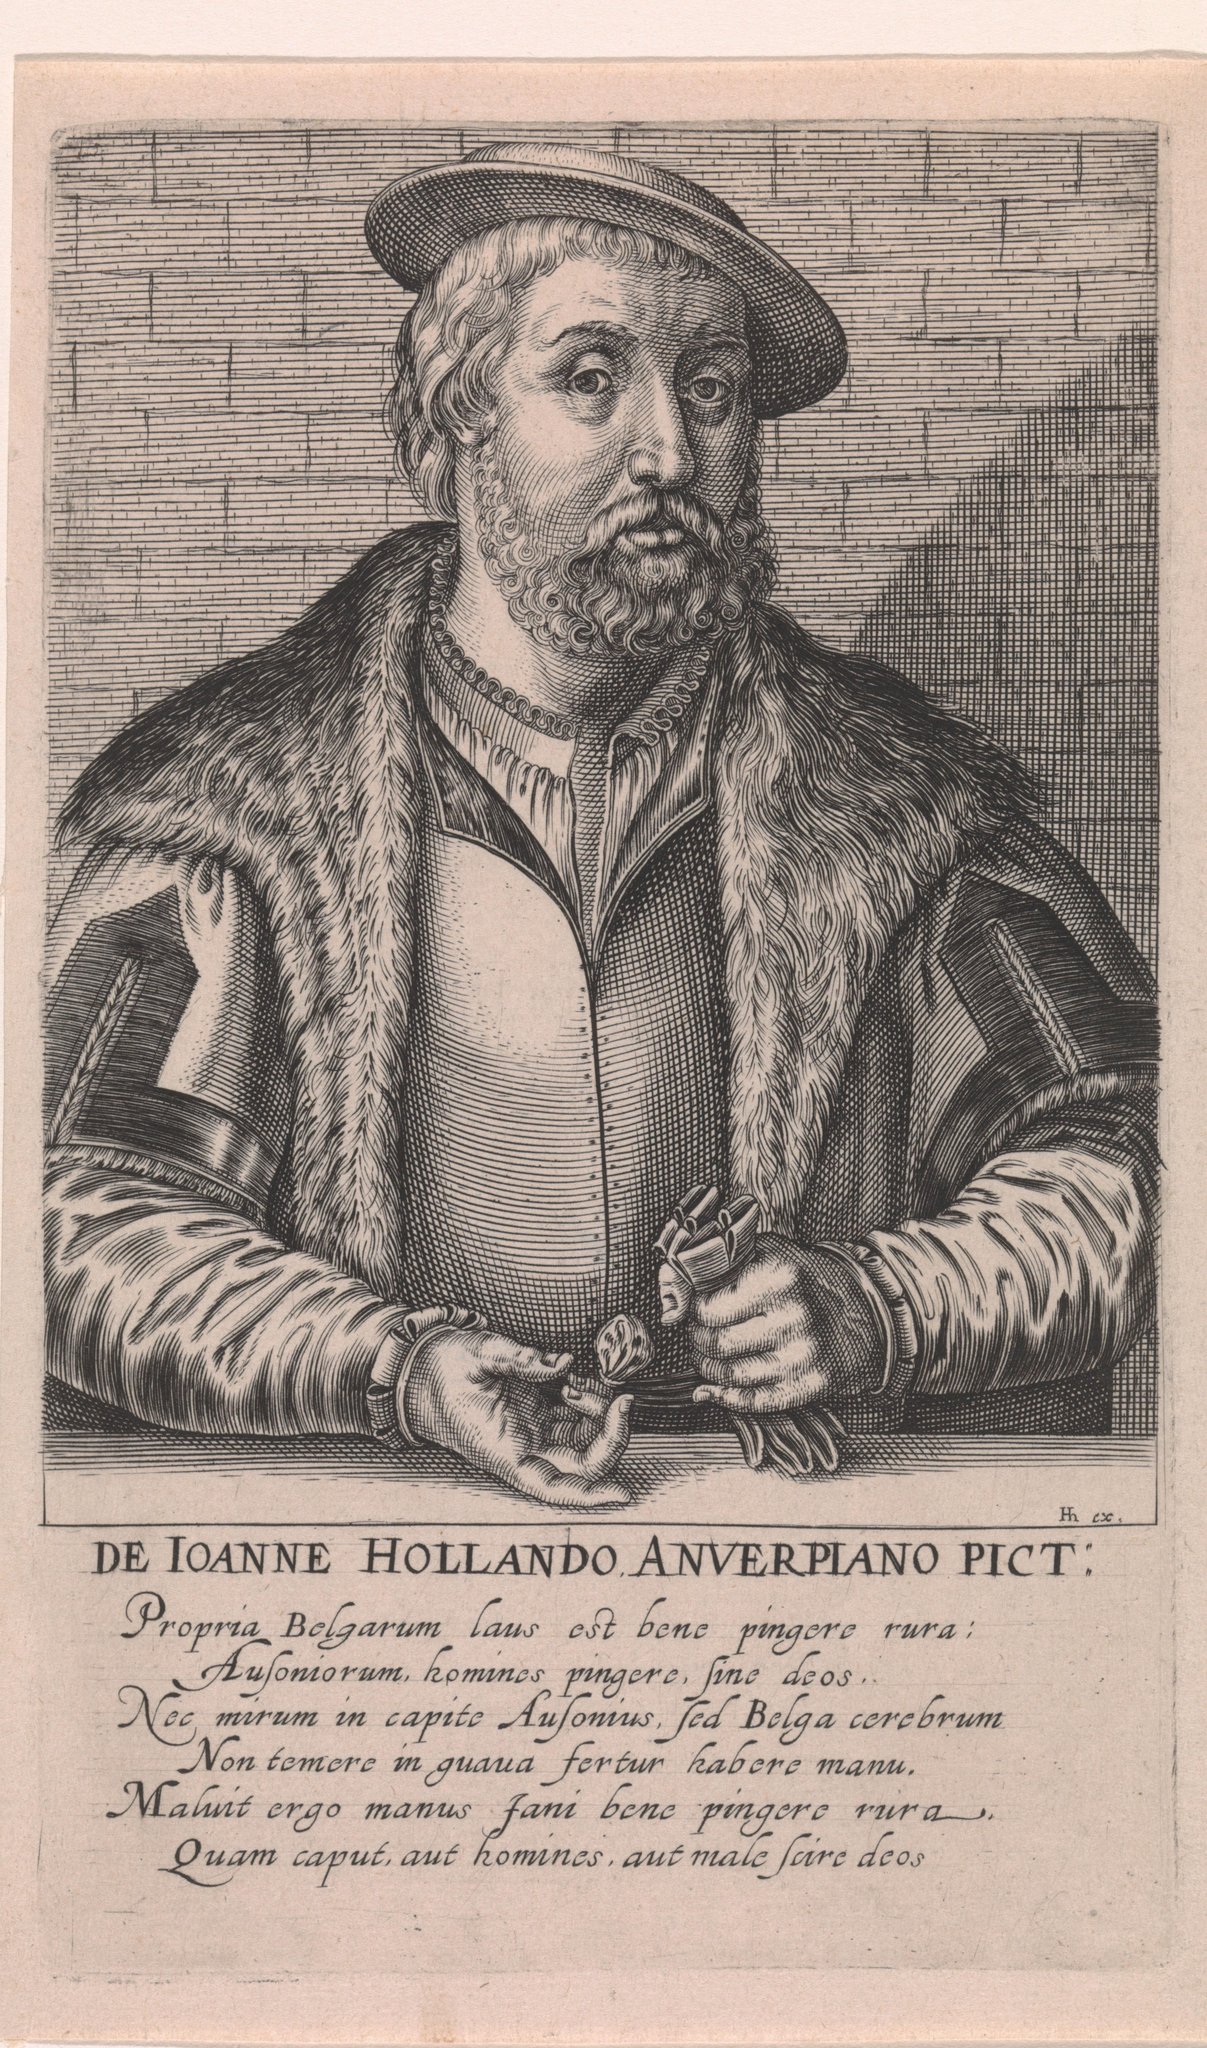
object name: print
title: De Ioanne Hollando Anverpiano pict:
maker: hendrick hondius (i)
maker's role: draughtsman, print maker, publisher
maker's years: 1573-1650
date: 1610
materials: paper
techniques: engraving, etching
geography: the hague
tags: amsterdam, antwerp, painter, draughtsman, portrait, self-portrait of painter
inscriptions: address: ‘Hh ex.’, collector's mark: Lugt 2228, caption: ‘DE IOANNE HOLLANDO ANTVERPIANO PICT’, caption: ‘Propria Belgarum laus...male scire deos’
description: Portret van Jan van Amstel. Onder het portret zijn naam en zes regels in het Latijn. Prent uit deel 1 van de serie Pictorum Aliquot Celebrium Praecipuae Germaniae Inferioris Effigies. Serie van 72 kunstenaarsportretten vervaardigd door Hendrick Hondius I, Simon Frisius, Andries Jacobsz. Stock en Robert de Baudous.